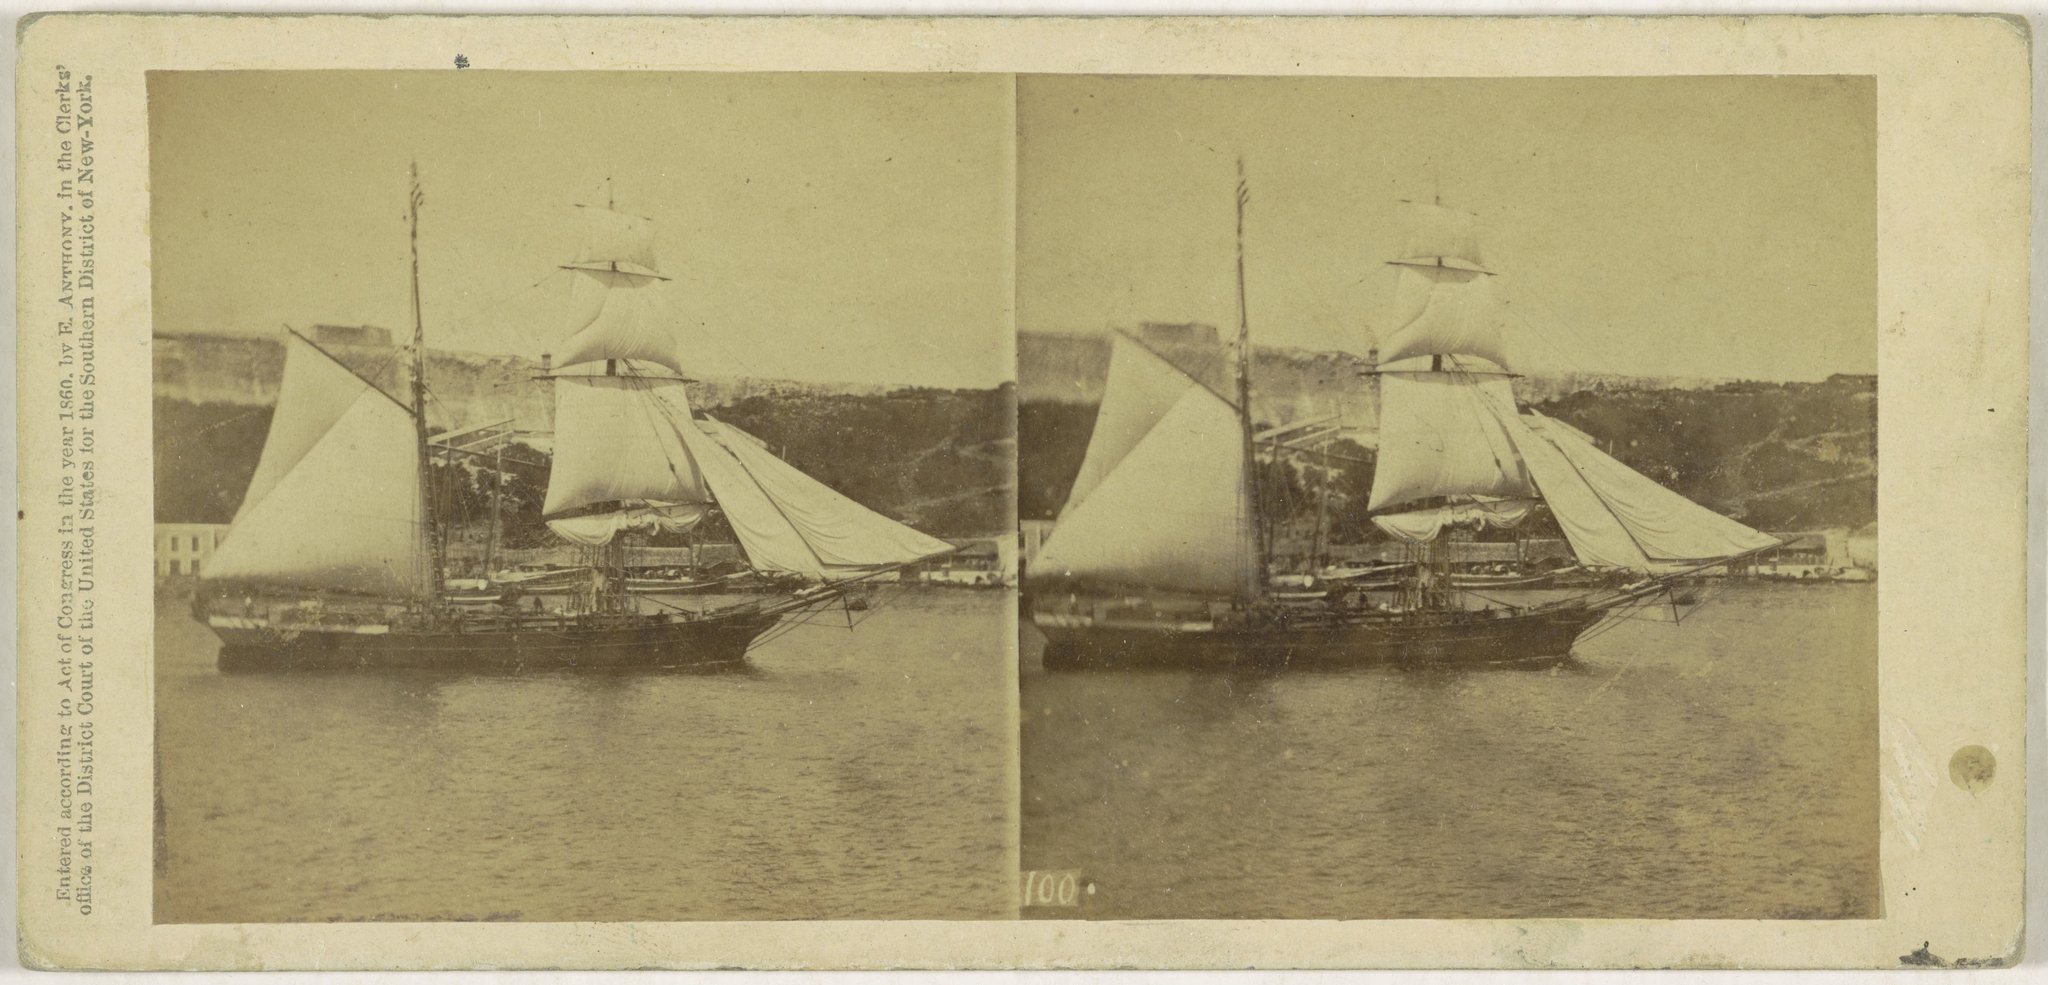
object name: stereograph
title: Instantaneous View. A Brigantine reefing her sails in the Harbor of Havana / Vista Instantánea. Un bergantin recogiendo vela en la bahia. Habana.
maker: Anonymous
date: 1860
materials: cardboard, paper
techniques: albumen print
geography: new york city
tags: ships (in general)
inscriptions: inscription: ‘Entered according to Act of Congress in the year 1860. by E. Anthony. in the Clerks'/ office of the District Court of the United States for the Southern District of New-York.’, number: ‘n: 115’, number: ‘100.’